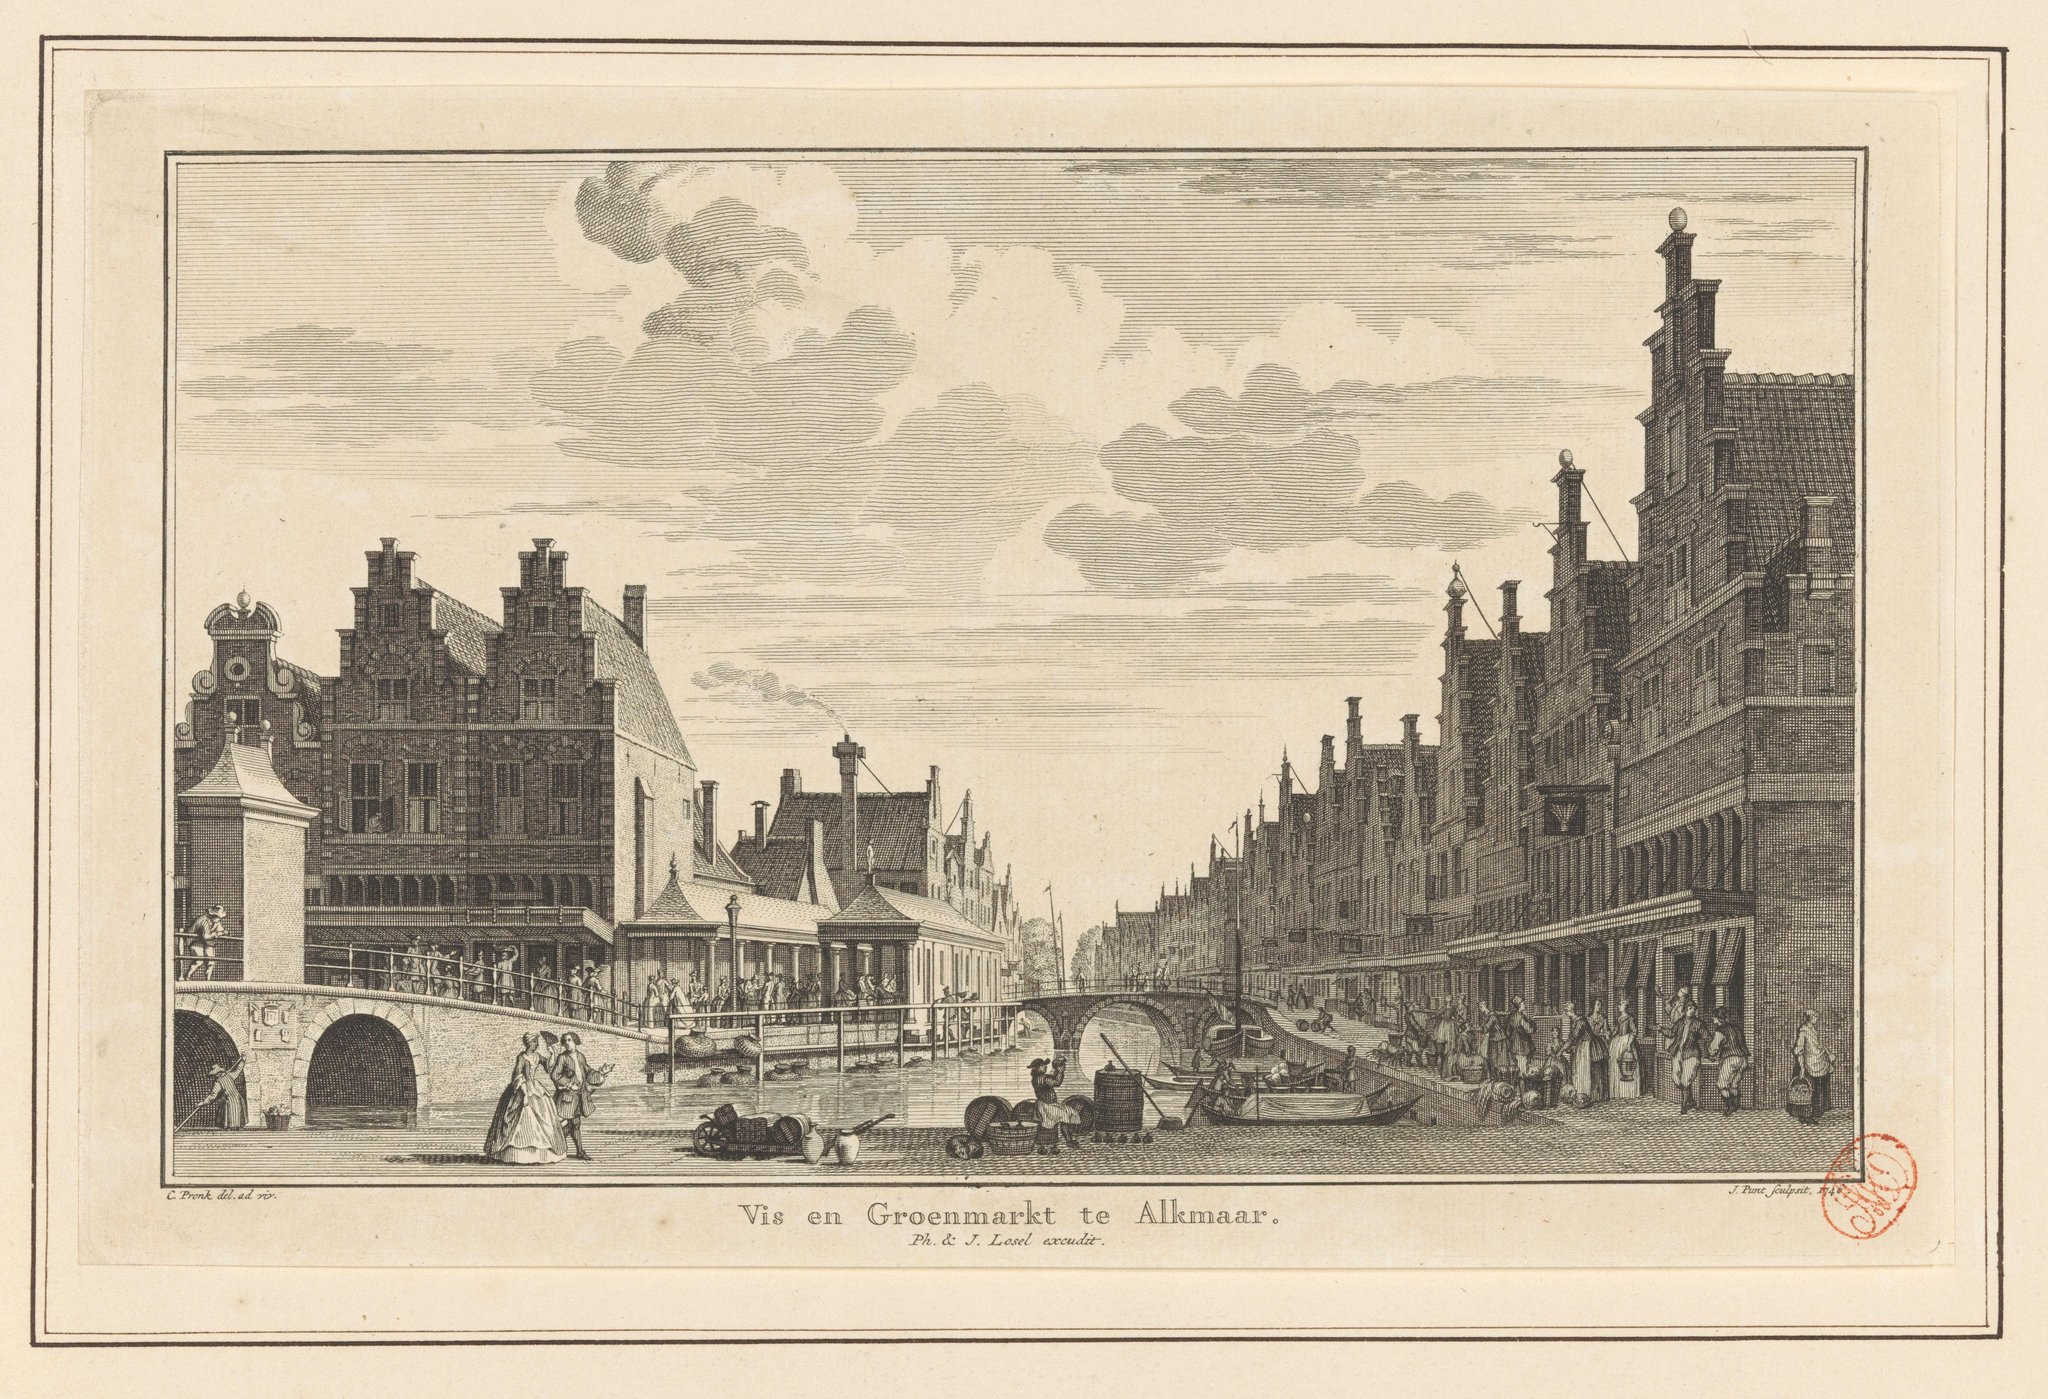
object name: print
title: Gezicht op de vis- en groentemarkt te Alkmaar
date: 1746-1747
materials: paper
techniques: engraving, etching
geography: amsterdam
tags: canals, waters (in city), market, bridge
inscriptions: collector's mark: Lugt 195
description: Prent gebruikt in: Boomkamp, Gysbert. Alkmaer en deszelfs geschiedenissen uit de nagelatene papieren van Simon Eikelenberg (...). Rotterdam: Philippus en Jakobus Losel, 1747. Zie ook RP-P-1905-659 en RP-P-AO-9A-5-1